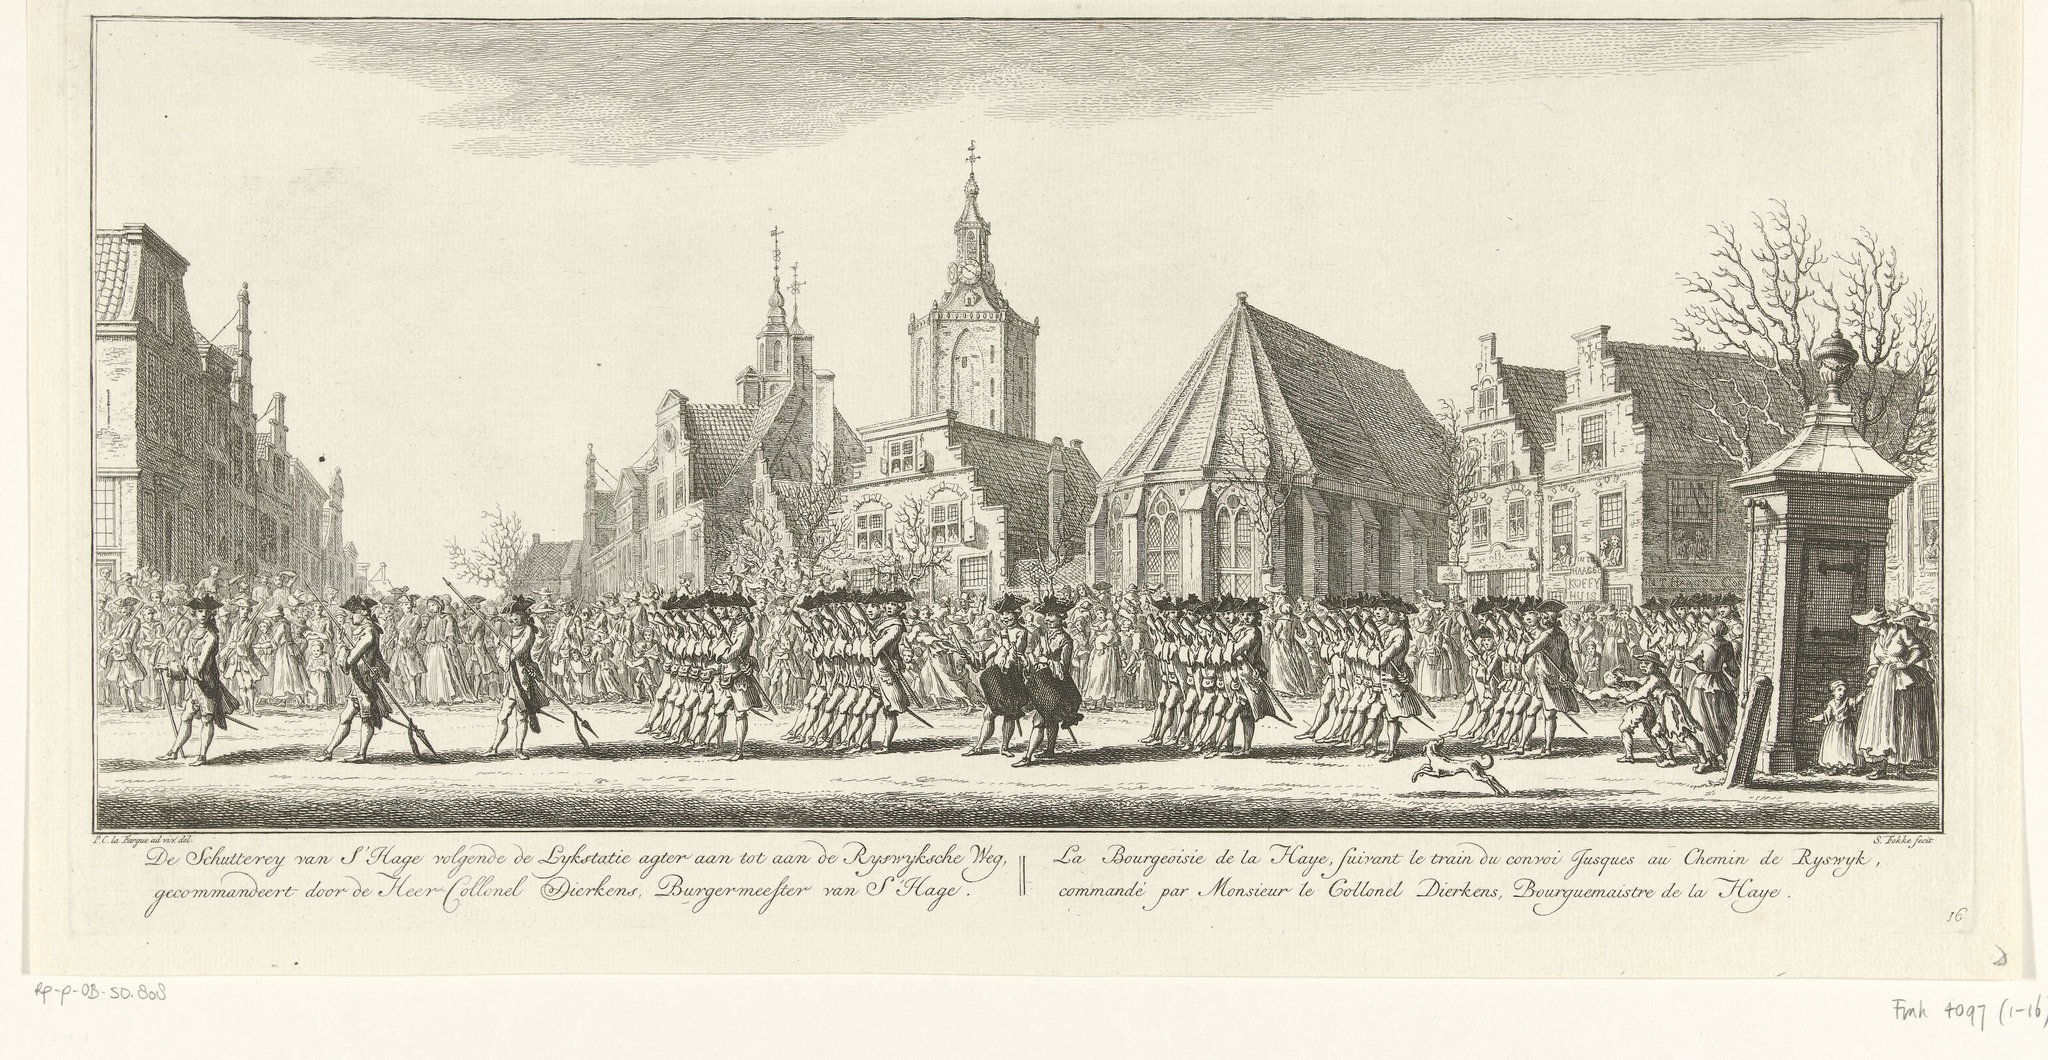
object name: print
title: Haagse schutterij in de lijkstoet van Anna van Hannover te Delft, 1759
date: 1759-1761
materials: paper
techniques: etching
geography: amsterdam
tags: anna van hannover, cortege, funeral procession, delft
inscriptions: collector's mark: Lugt 2228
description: Haagse schutterij in de lijkstoet van Anna van Hannover, prinses van Oranje-Nassau, te Delft. Onder de voorstelling staat een tweeregelig onderschrift in het Nederlands en Frans.